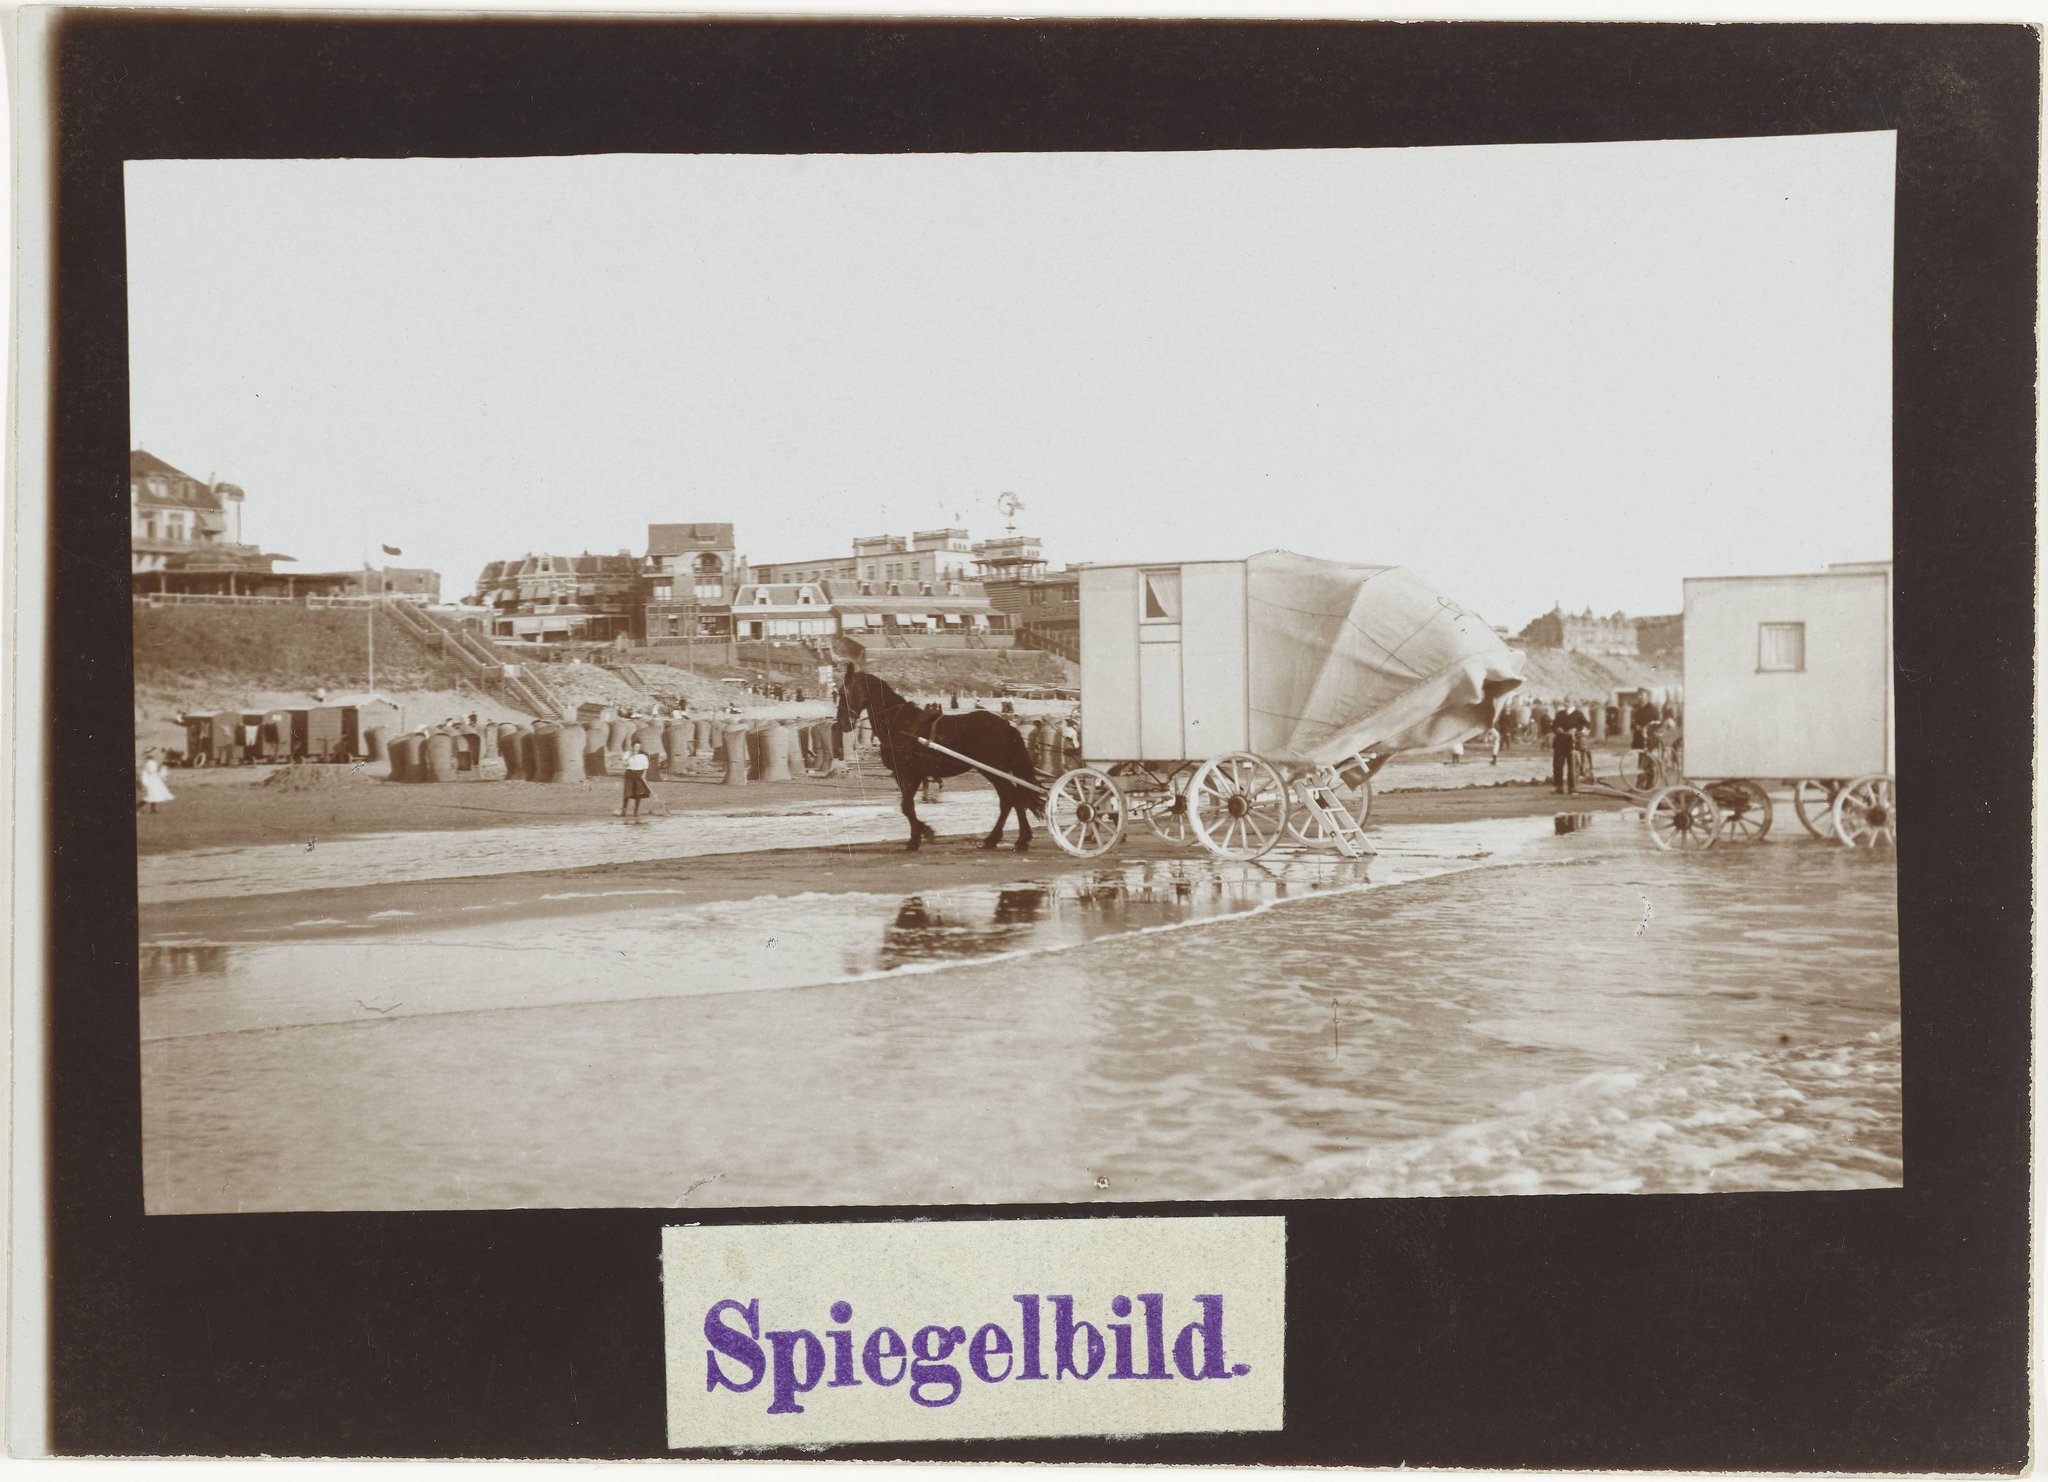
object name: photograph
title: Badkoetsje met paard op het strand in Zandvoort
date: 1900-1905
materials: photographic support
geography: zandvoort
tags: beach (as place of recreation)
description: Badkoetsje met een paard ervoor bij de vloedlijn. tegen de duinen aan strandstoelen en hotels. M.o. opschrift 'Spiegelbild'.